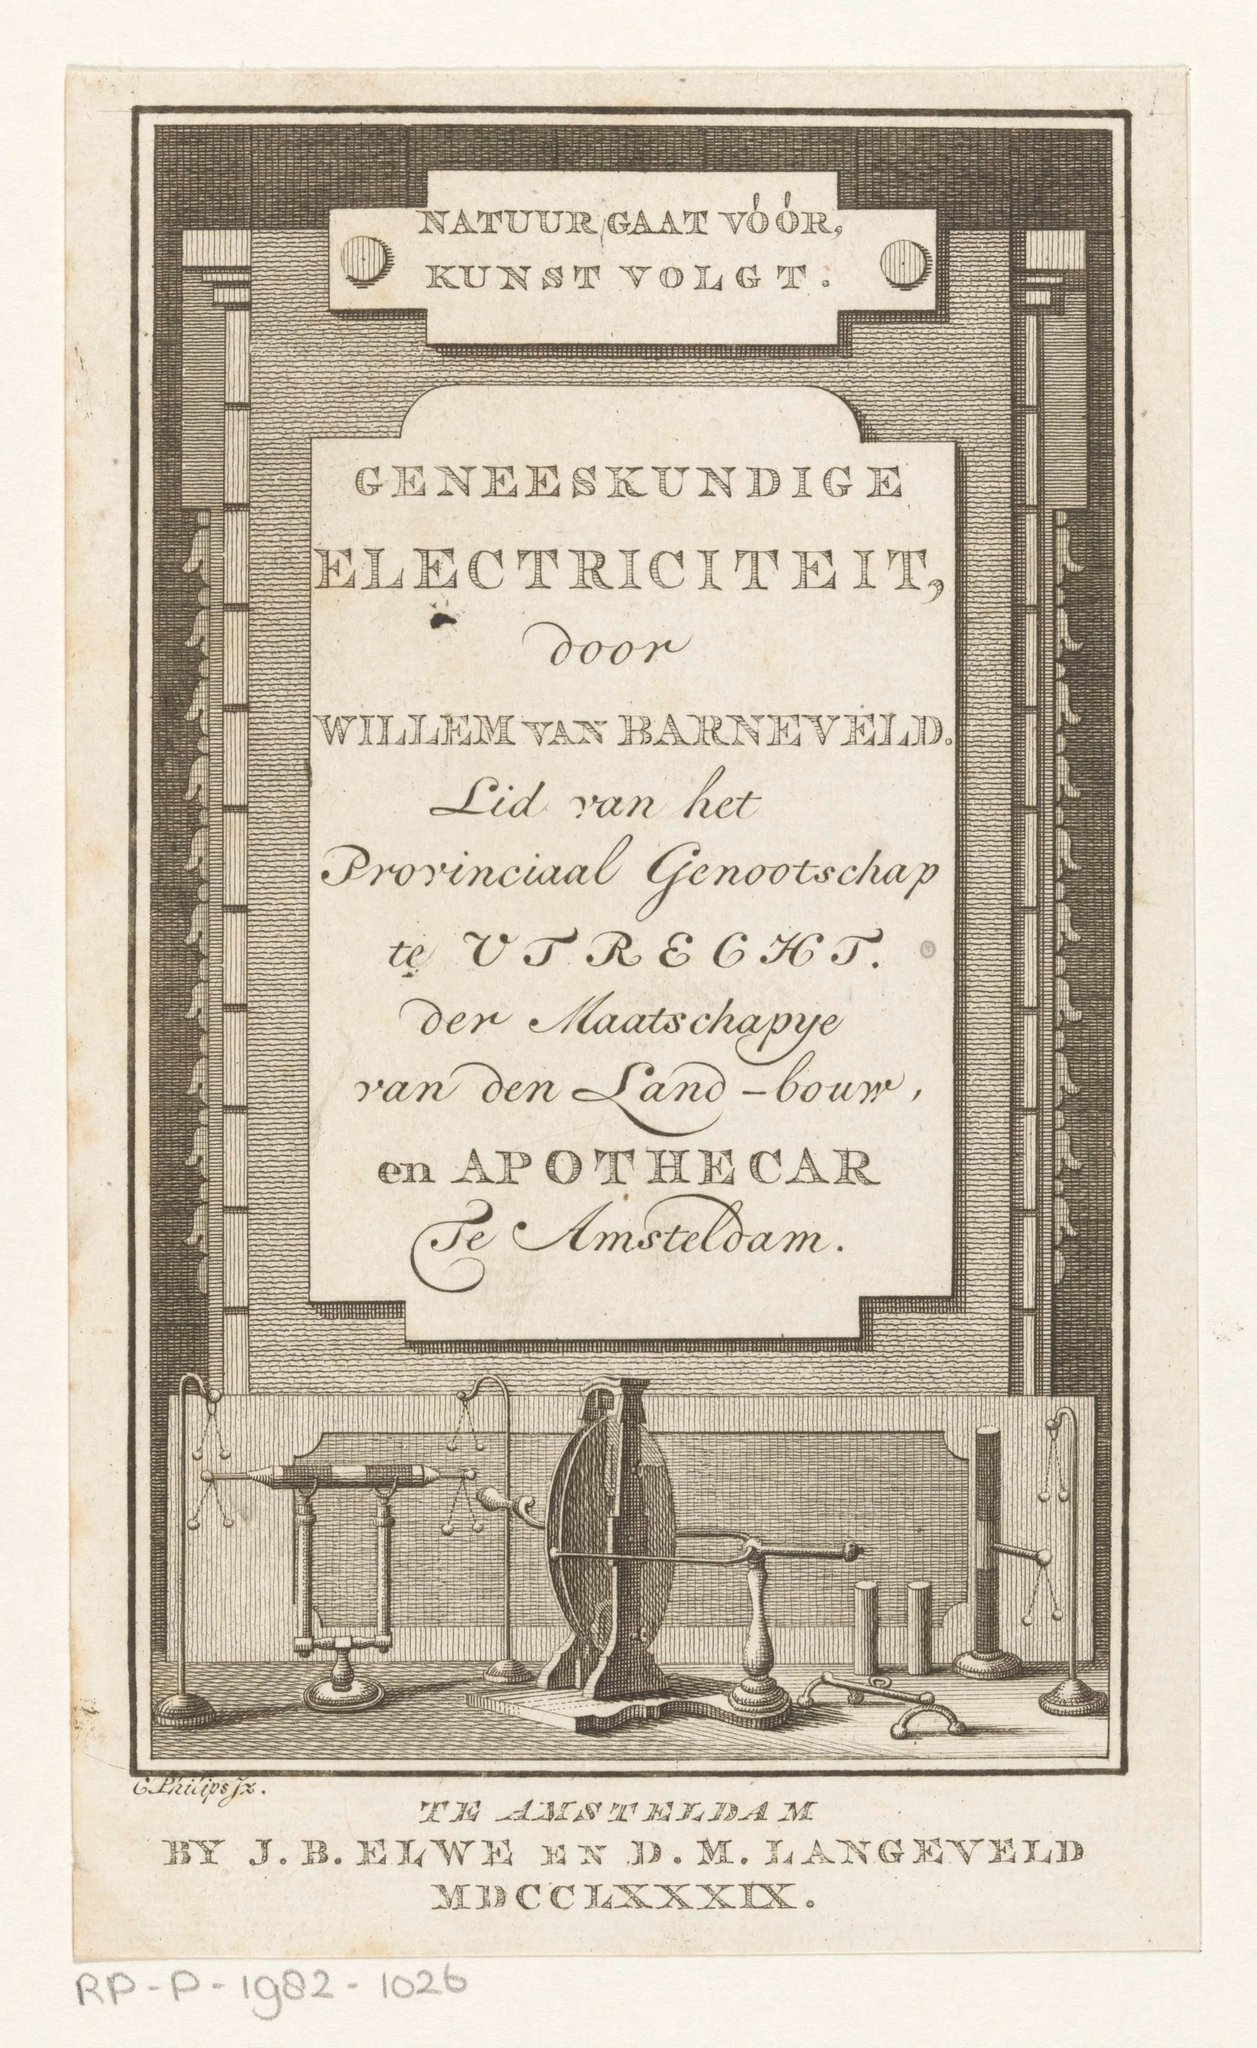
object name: titelblad, titelpagina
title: Geneeskundige of natuurkundige objecten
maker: caspar philips jansz.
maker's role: publisher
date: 1789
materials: paper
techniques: engraving, etching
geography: amsterdam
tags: health, physics (+ tools, instruments; laboratory equipment ~ scientific research)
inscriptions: collector's mark: Lugt 2228, collector's mark: Lugt 2760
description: Titelpagina voor: Barneveld, Willem van. Geneeskundige Electriciteit. Amsterdam: Elwe & Langeveld, 1789.